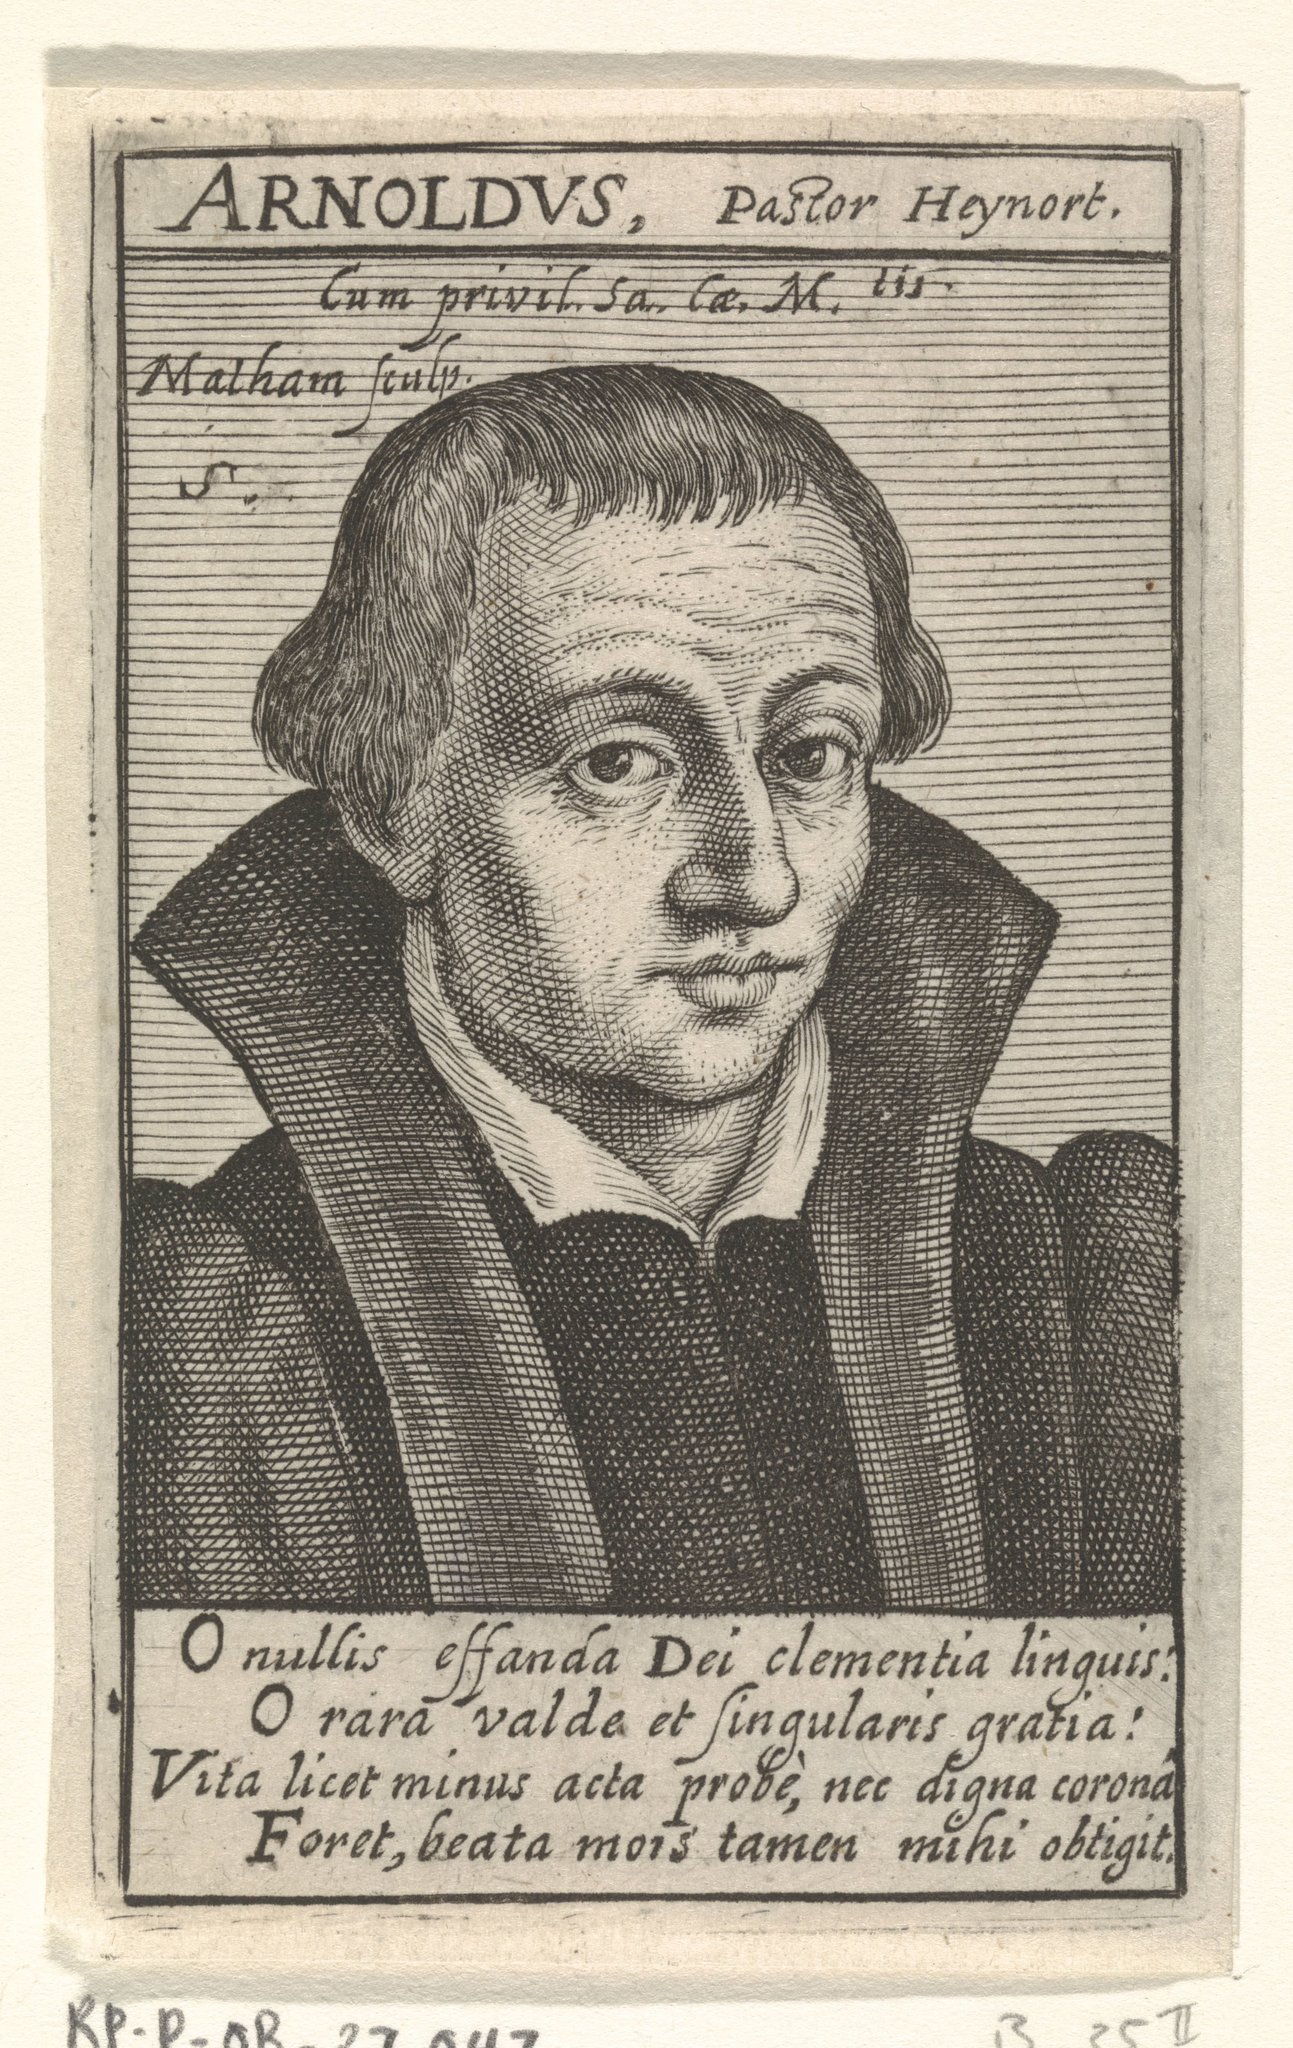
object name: print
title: Portret van H. Arnoldus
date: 1617-1618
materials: paper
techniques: engraving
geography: haarlem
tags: martyrs of gorkum, brielle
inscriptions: collector's mark: Lugt 2228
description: Portret van de heilige Arnoldus, mogelijk Andreas Wouters, een van de negentien katholieke martelaren van Gorinchem.